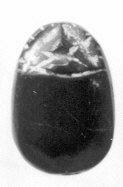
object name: stamp seal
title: Scarab seal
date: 1700-1560 BCE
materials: jasper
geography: levant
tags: scarabs